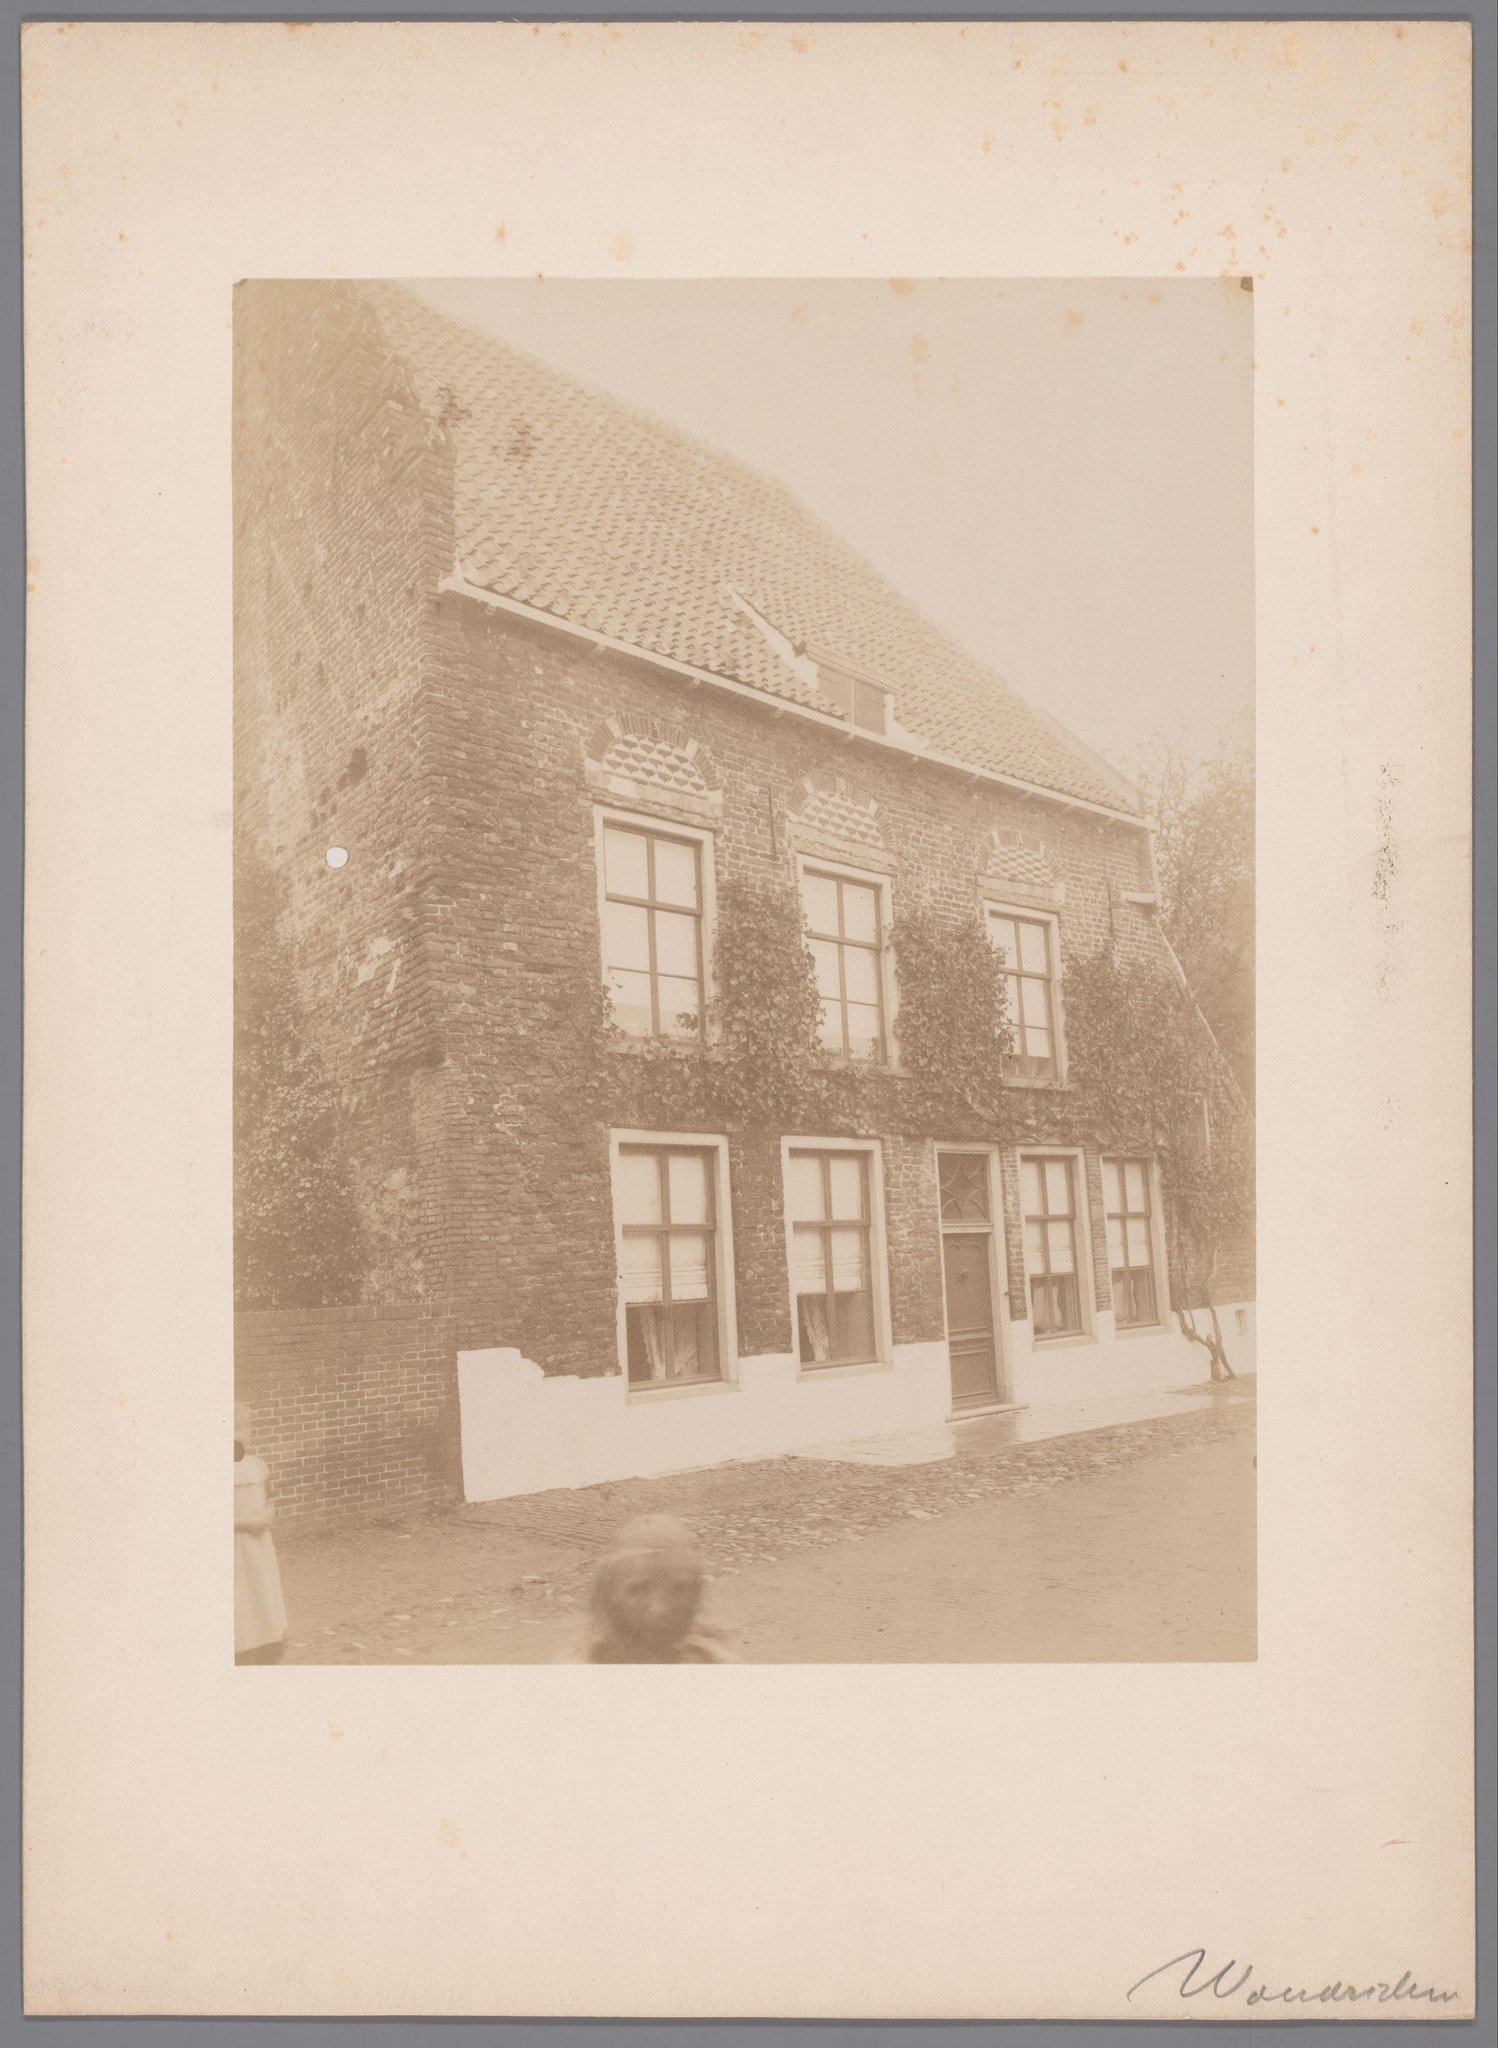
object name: photograph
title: Gevel van het klooster op Molenstraat 75 te Woudrichem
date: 1901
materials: cardboard, photographic support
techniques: albumen print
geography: woudrichem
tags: abbey, monastery, convent ~ roman catholic church, façade (of house or building), woudrichem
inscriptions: annotation: ‘Woudrichem’, annotation: ‘Woudrichem oct 1901 (N.B.)/ Molenstraat 75/ gedeelte v/e oud klooster’